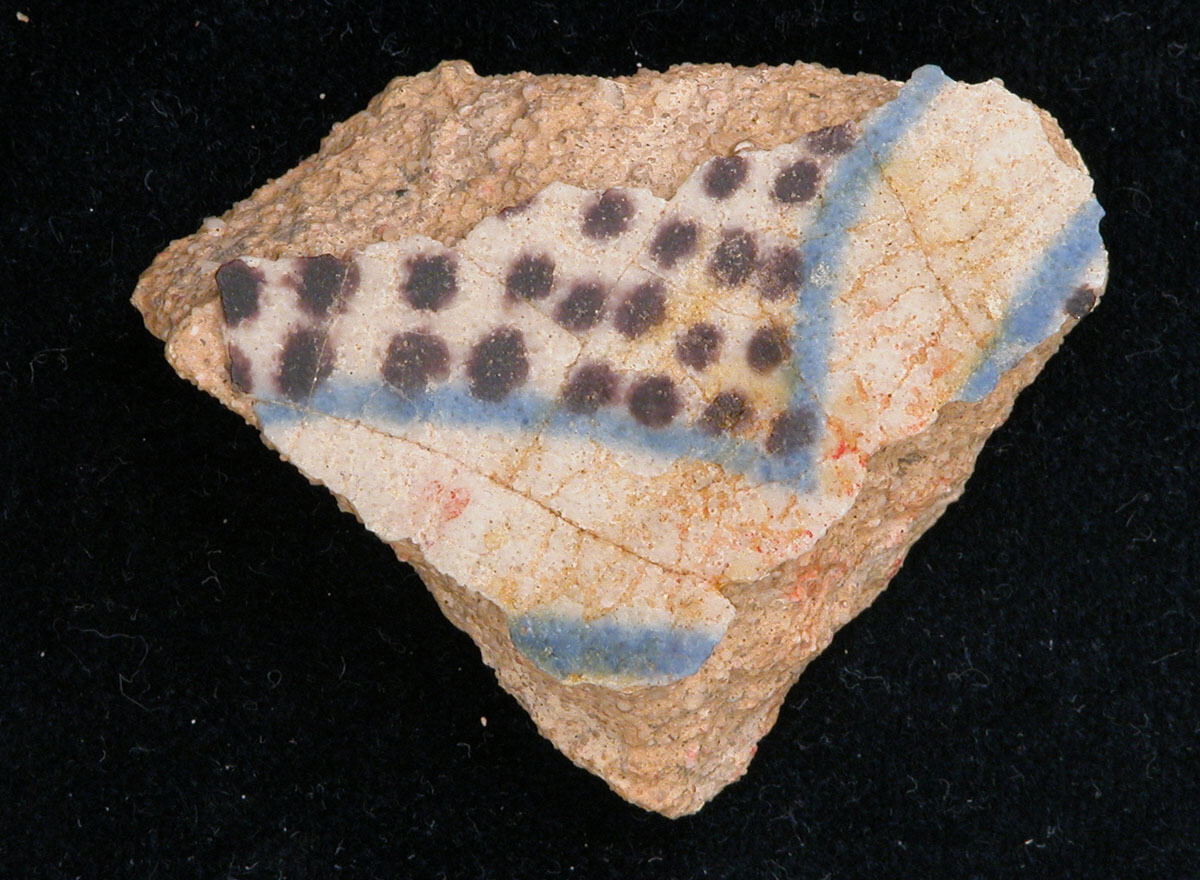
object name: fragment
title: Ceramic Fragment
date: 1201-1300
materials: stonepaste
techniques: glazing, incising, painting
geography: saudi arabia